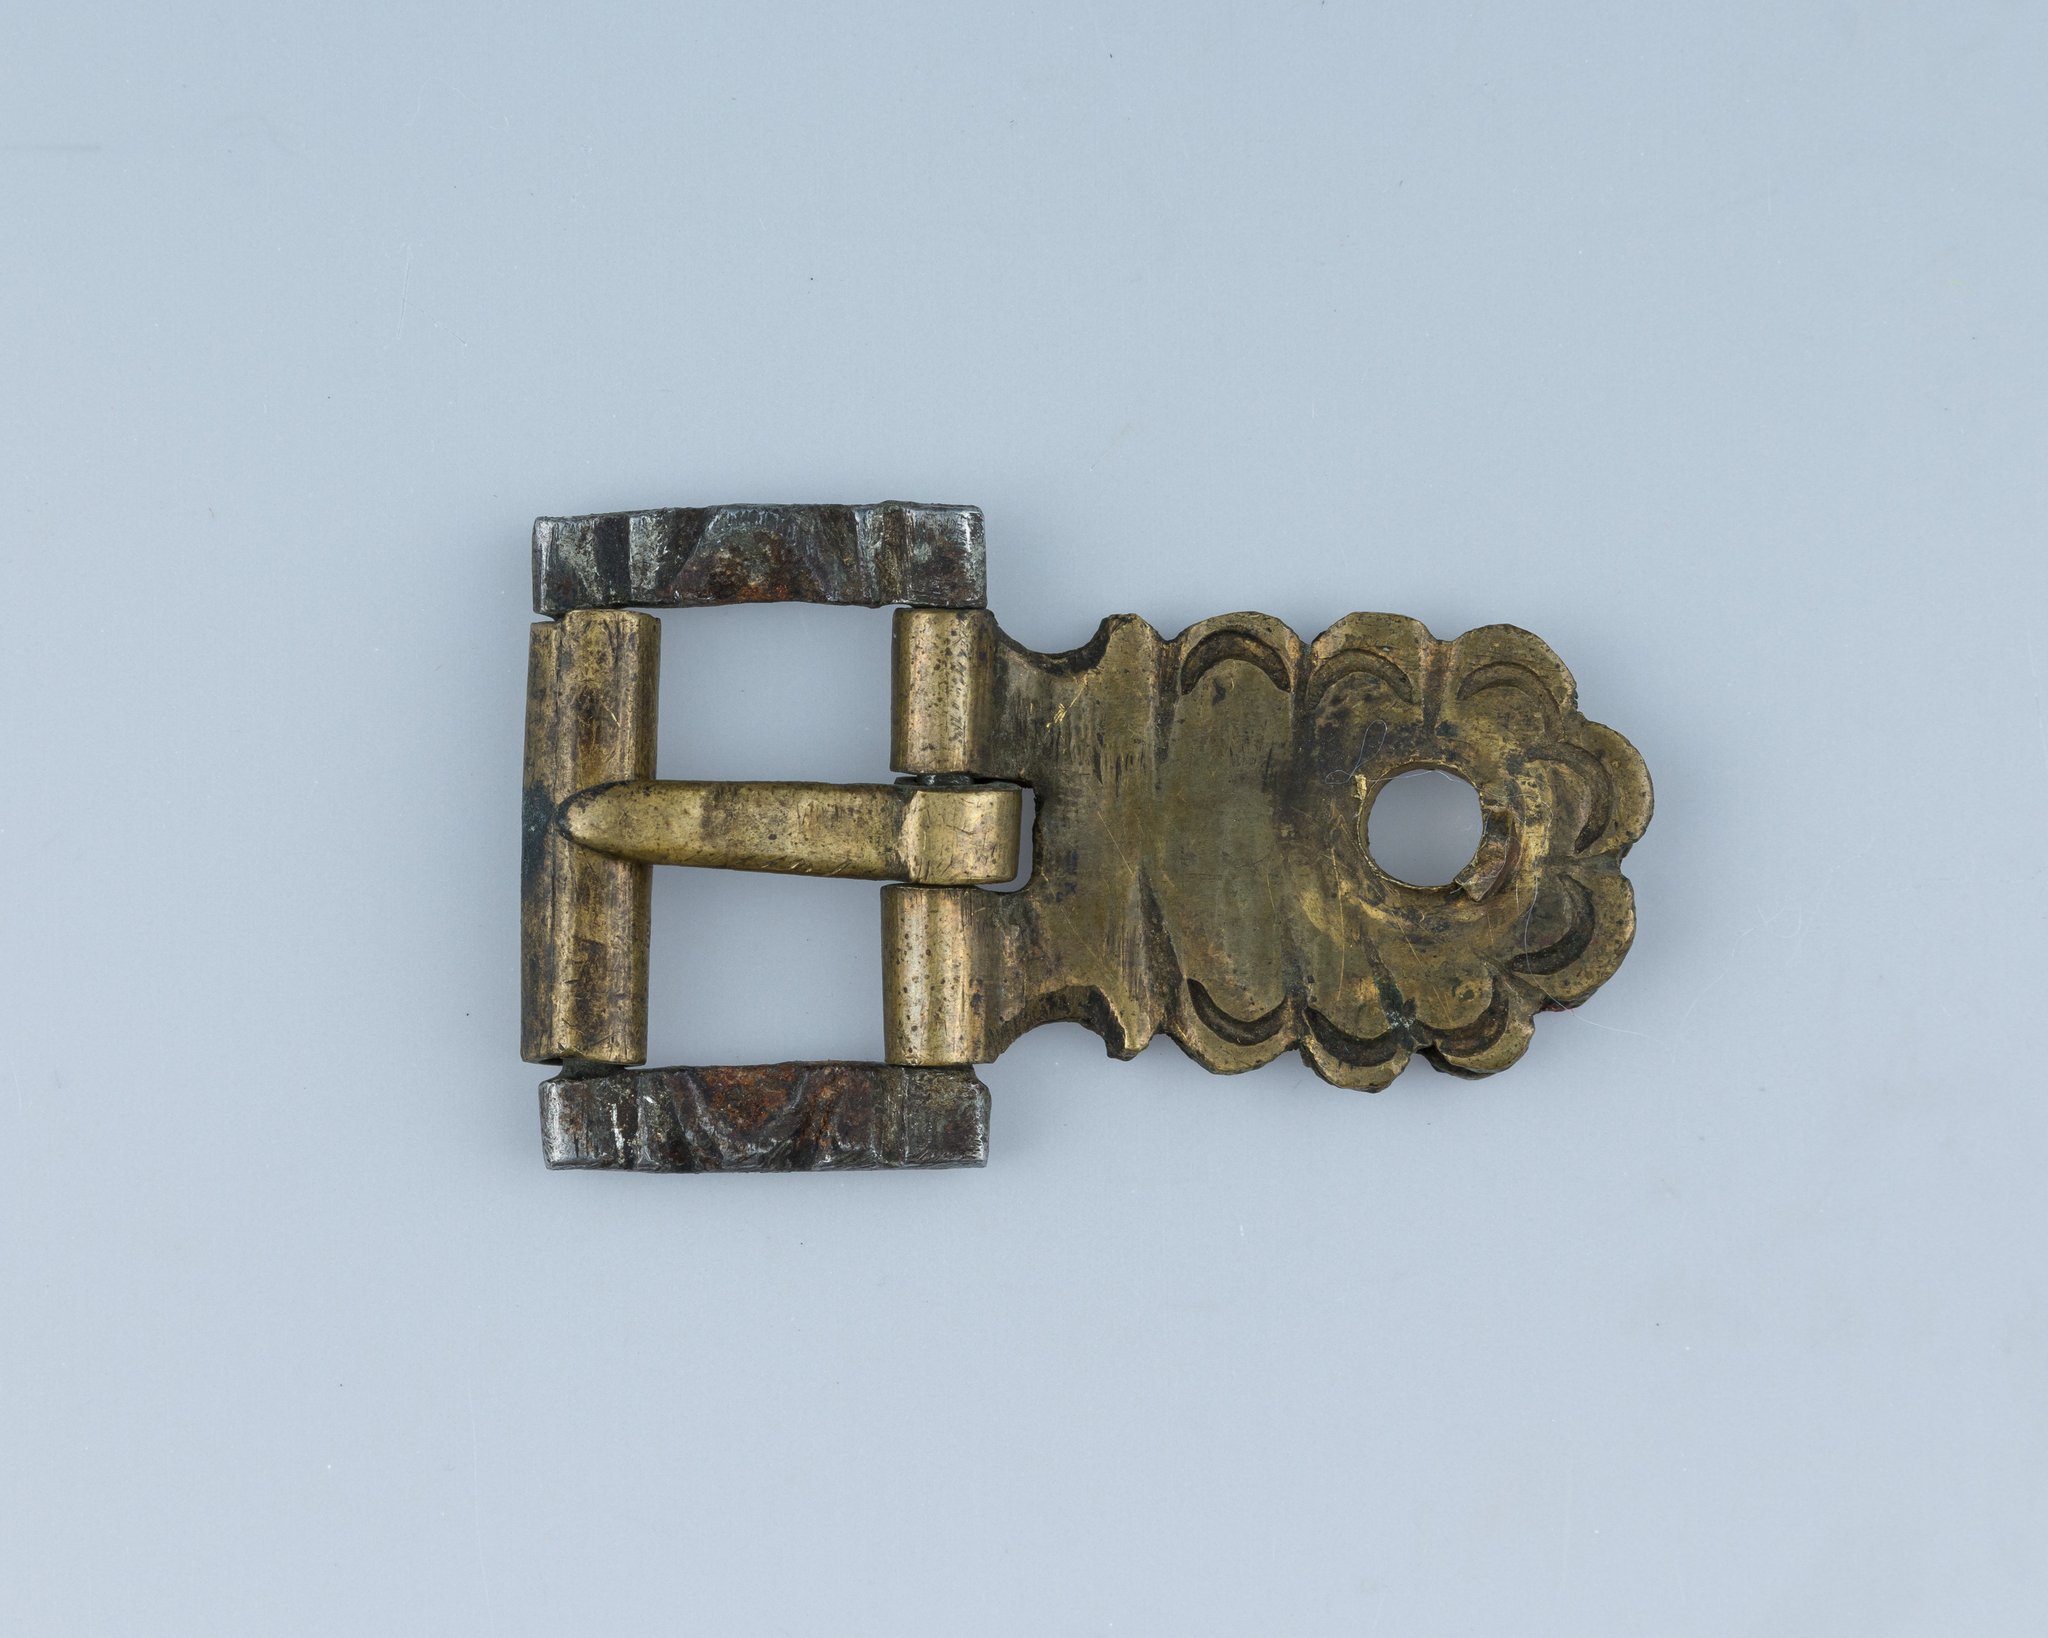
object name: buckle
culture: german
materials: brass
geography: germany